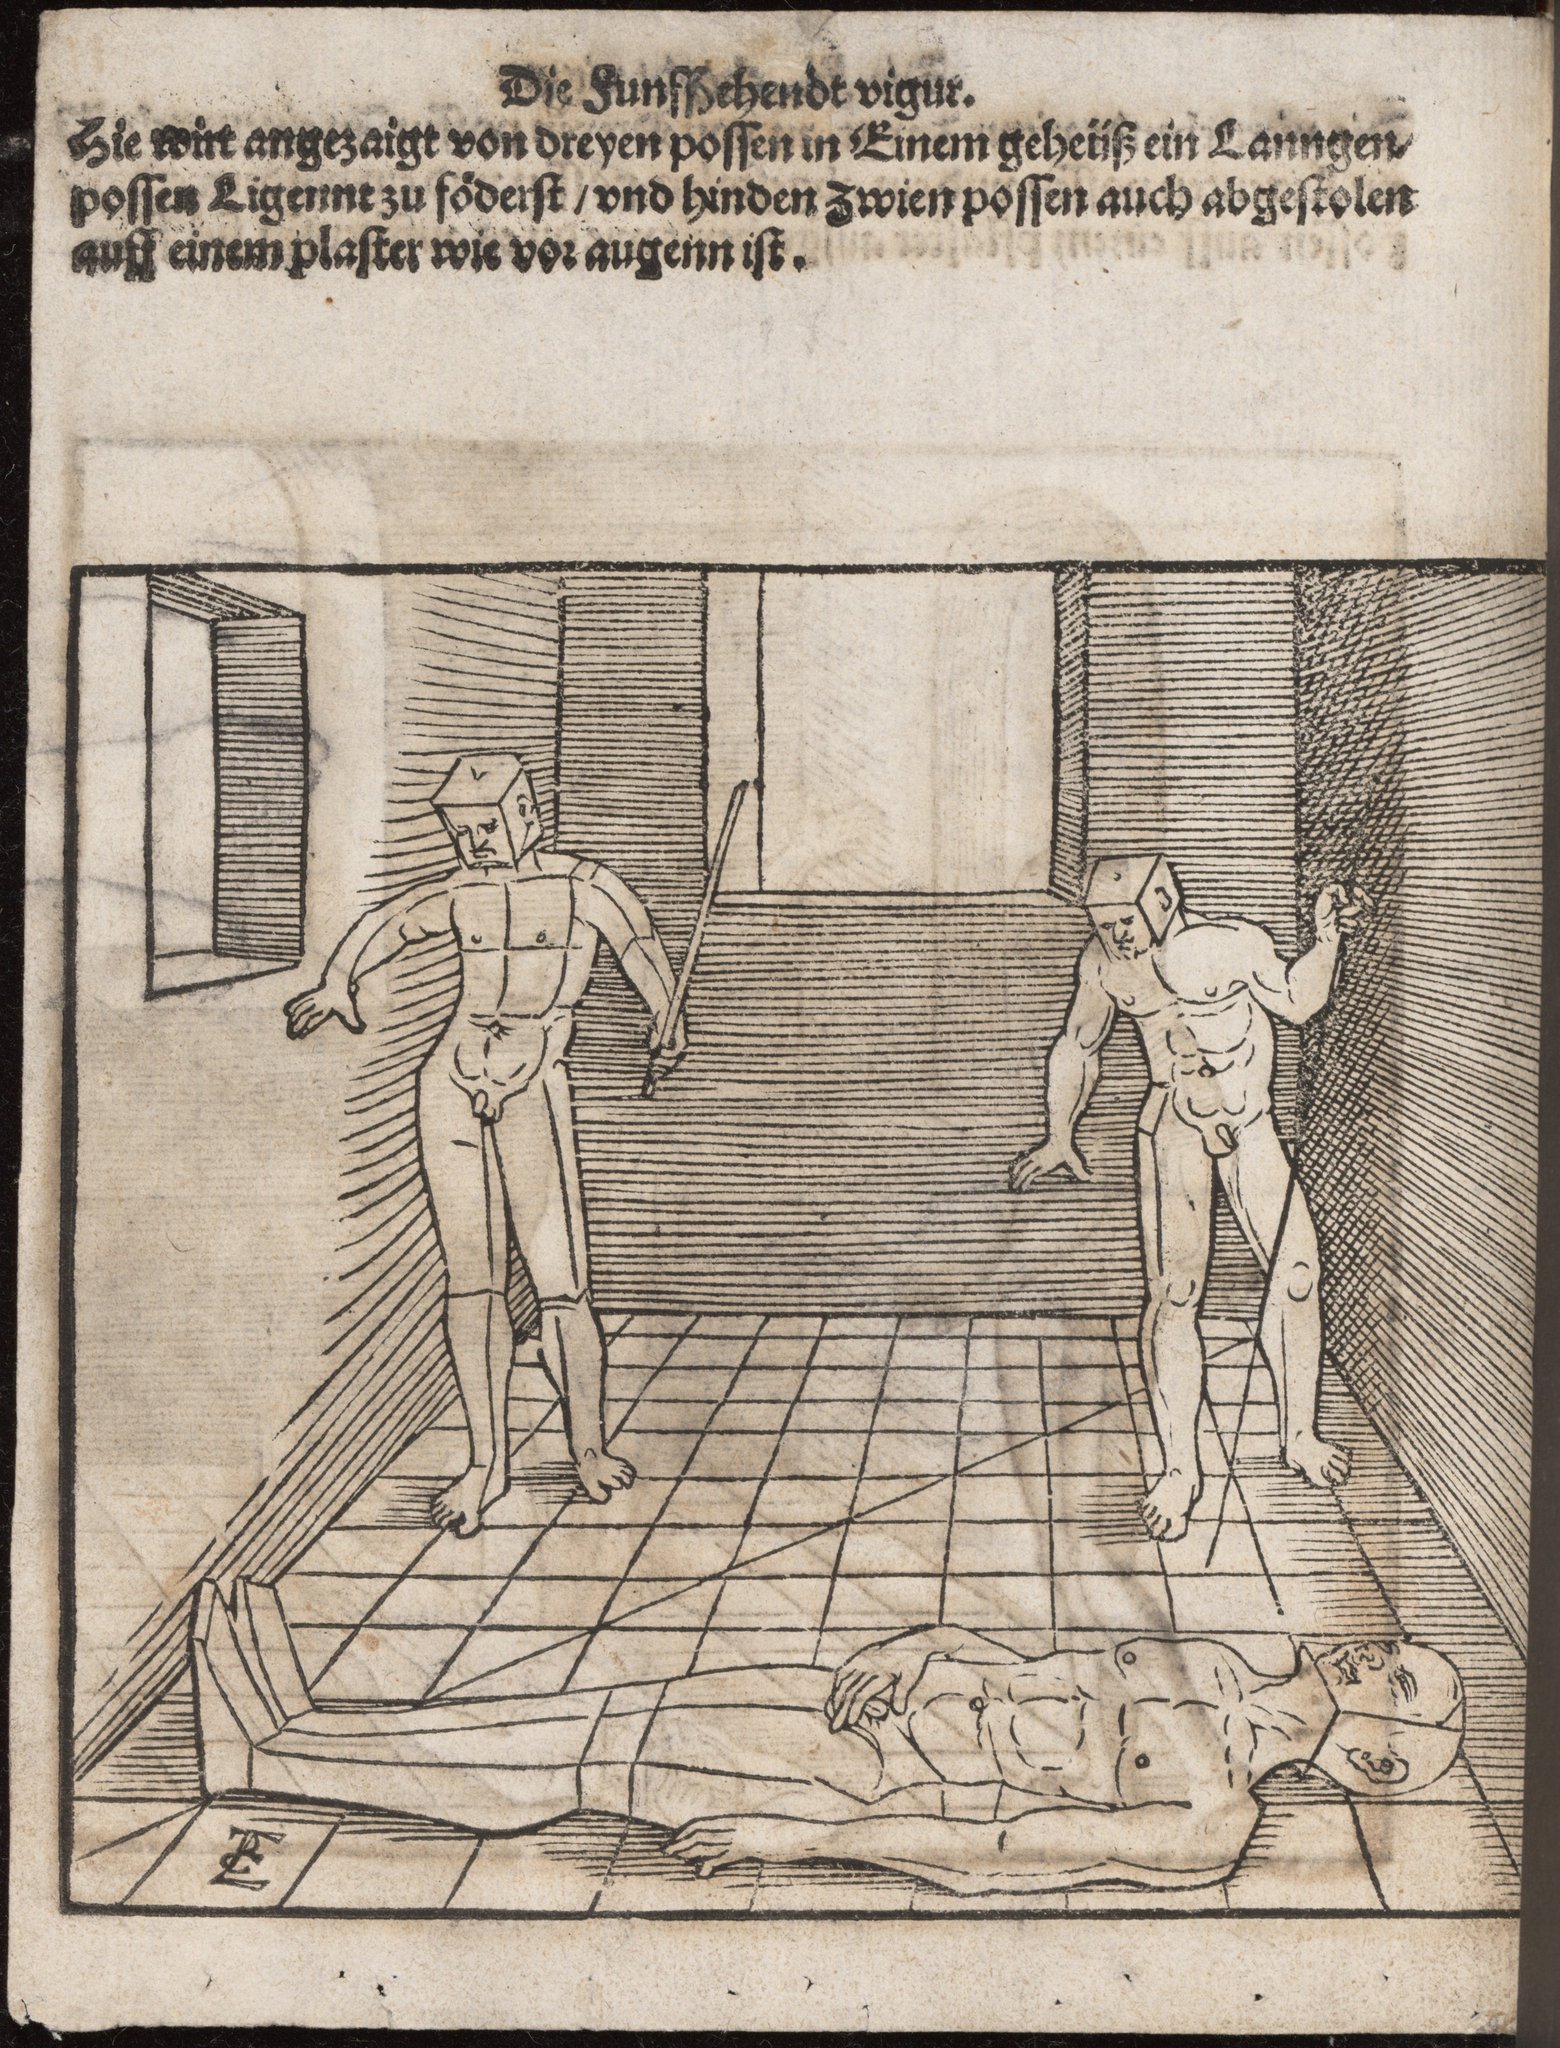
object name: book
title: Underweissung der Proportzion und stellung der possen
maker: erhard schön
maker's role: designer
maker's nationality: german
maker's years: 1491-1542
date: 1538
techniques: woodcut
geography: germany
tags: male nudes,geometry